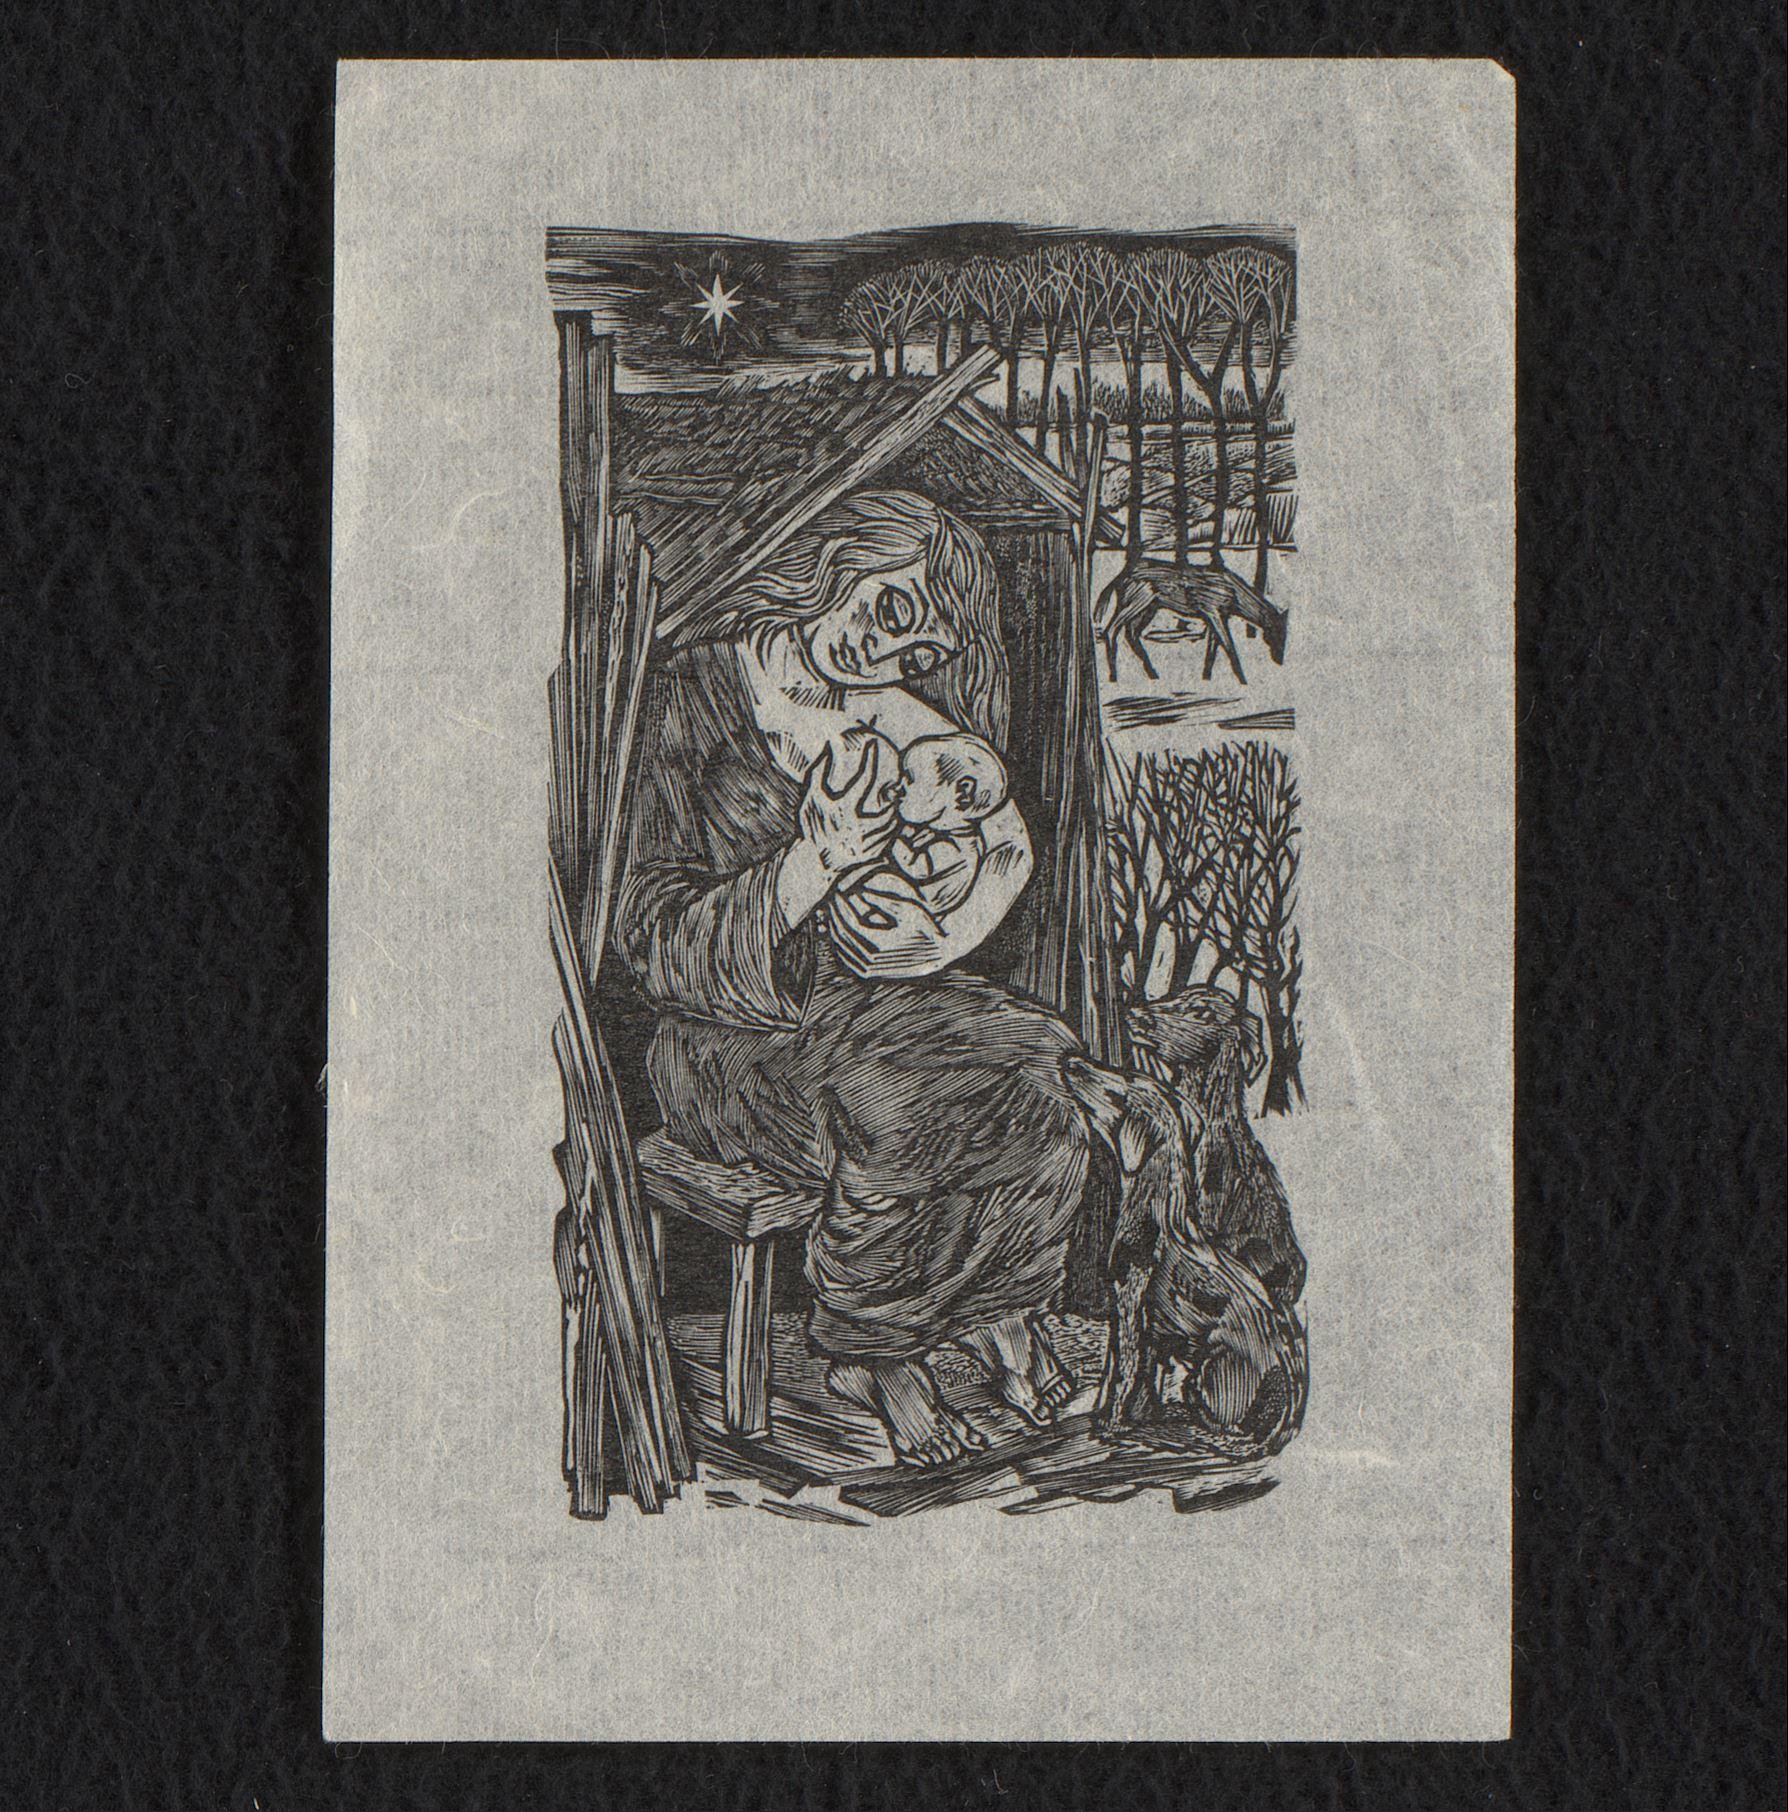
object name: print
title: Maria met Christus aan de borst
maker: Anonymous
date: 1930-1980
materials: paper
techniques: engraving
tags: christ-child suckling, or beginning to suckle, e.g. mary uncovering her breast ~ madonna-representations